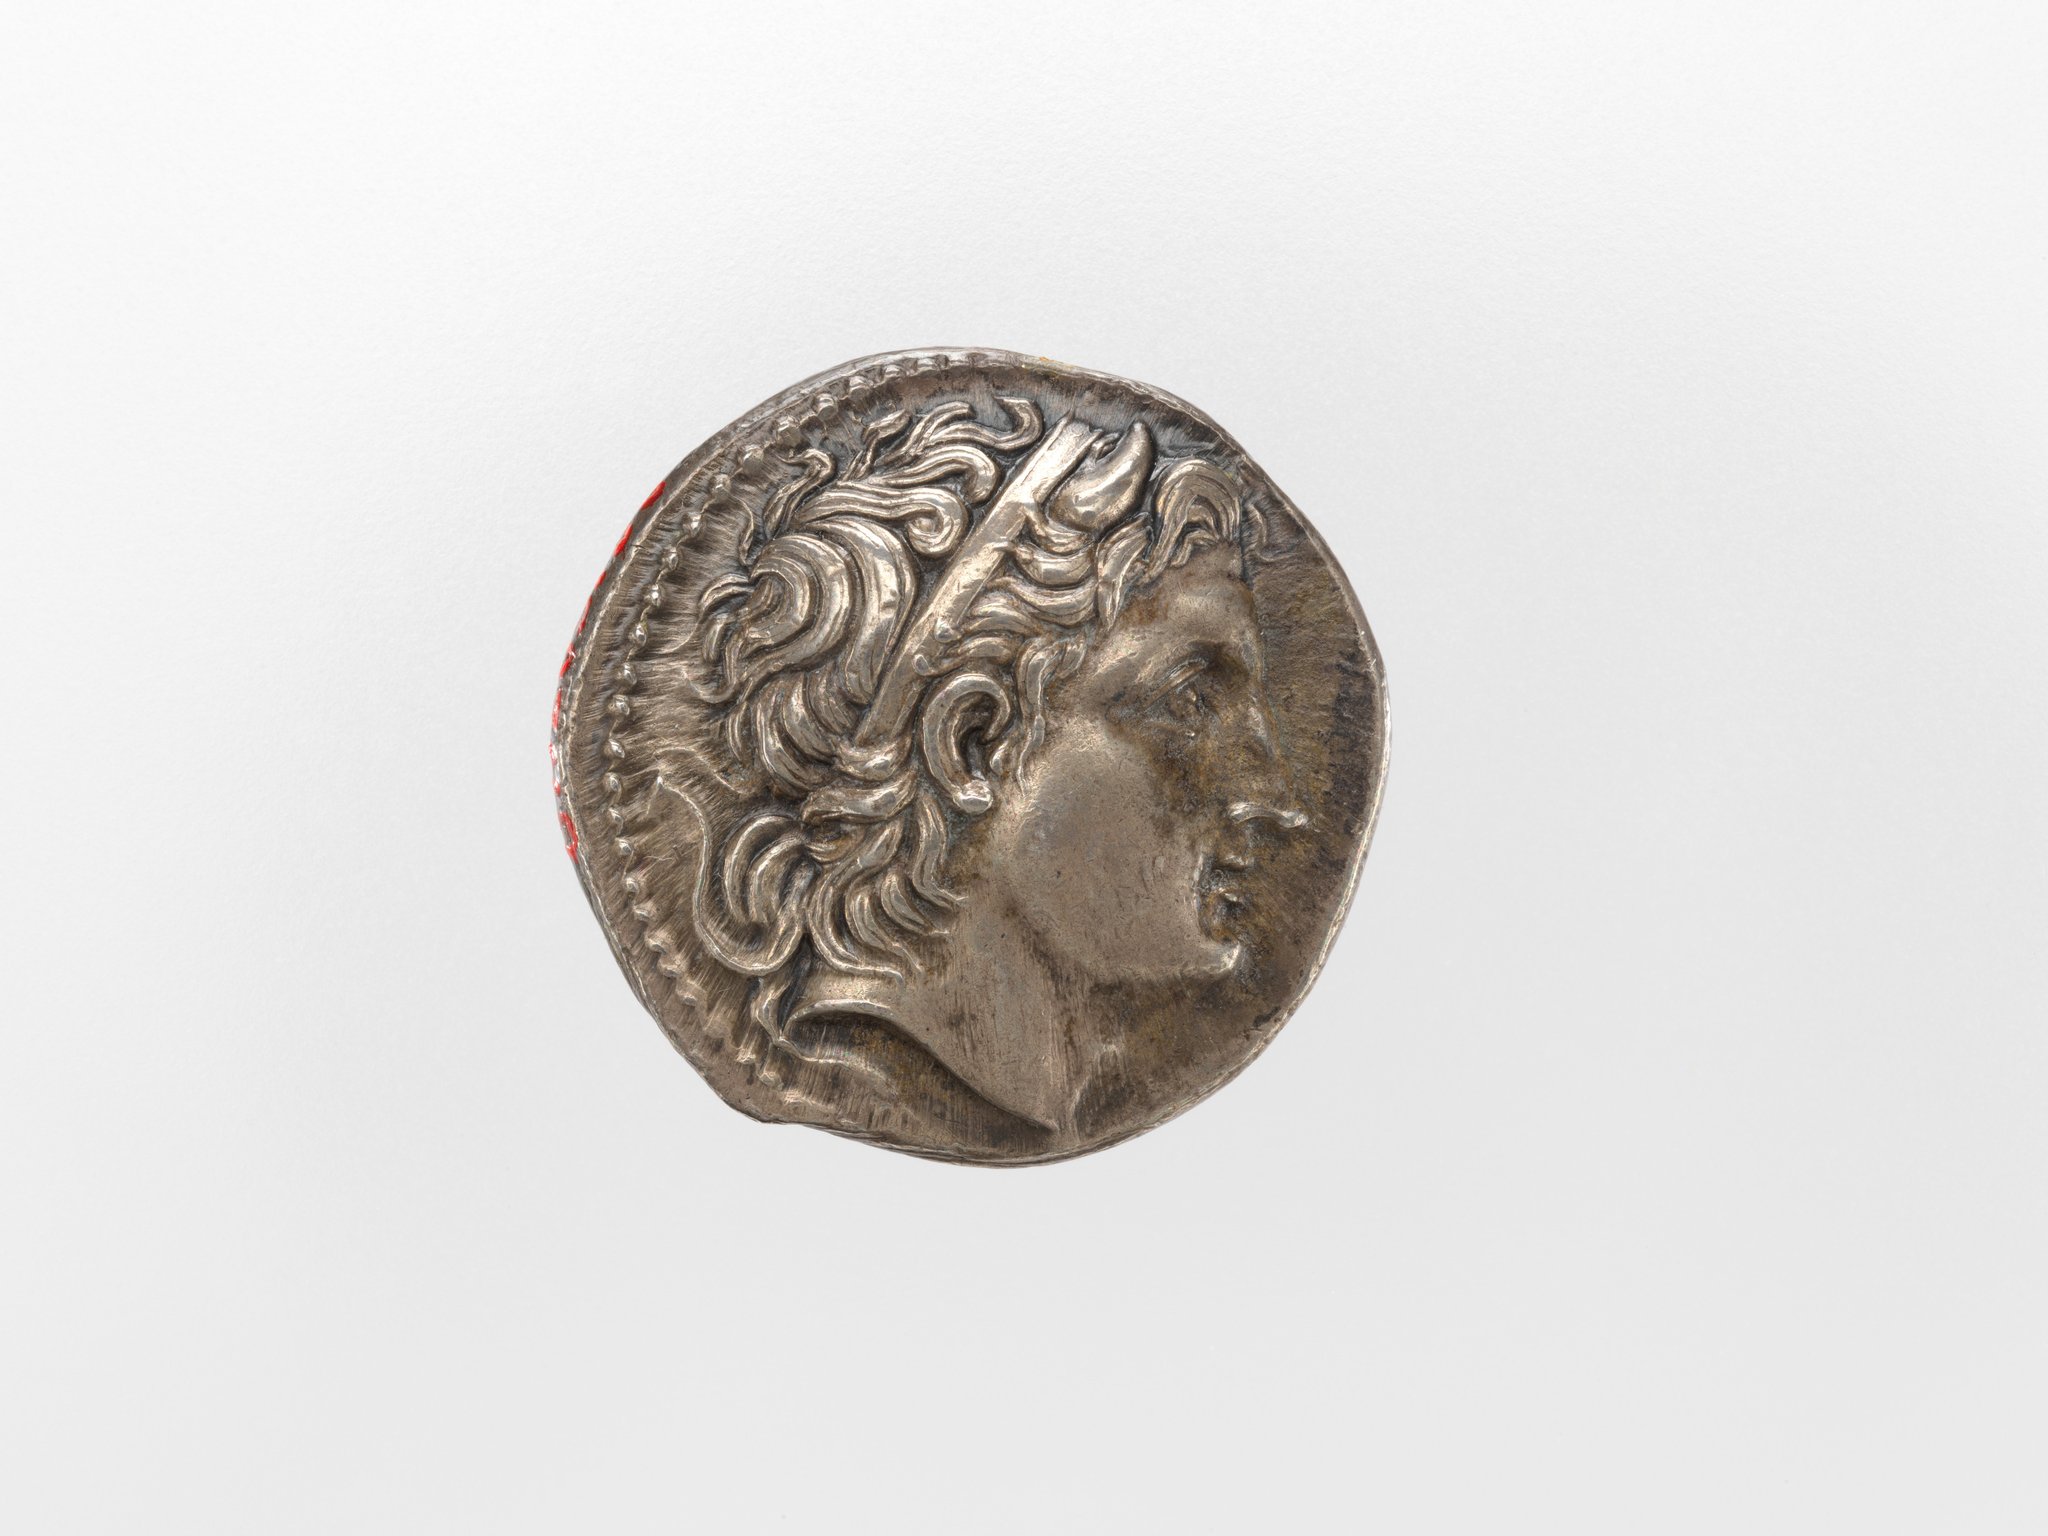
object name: tetradrachm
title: Silver tetradrachm of Demetrios Poliorketes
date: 289-288 BCE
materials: silver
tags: men,profiles,coins